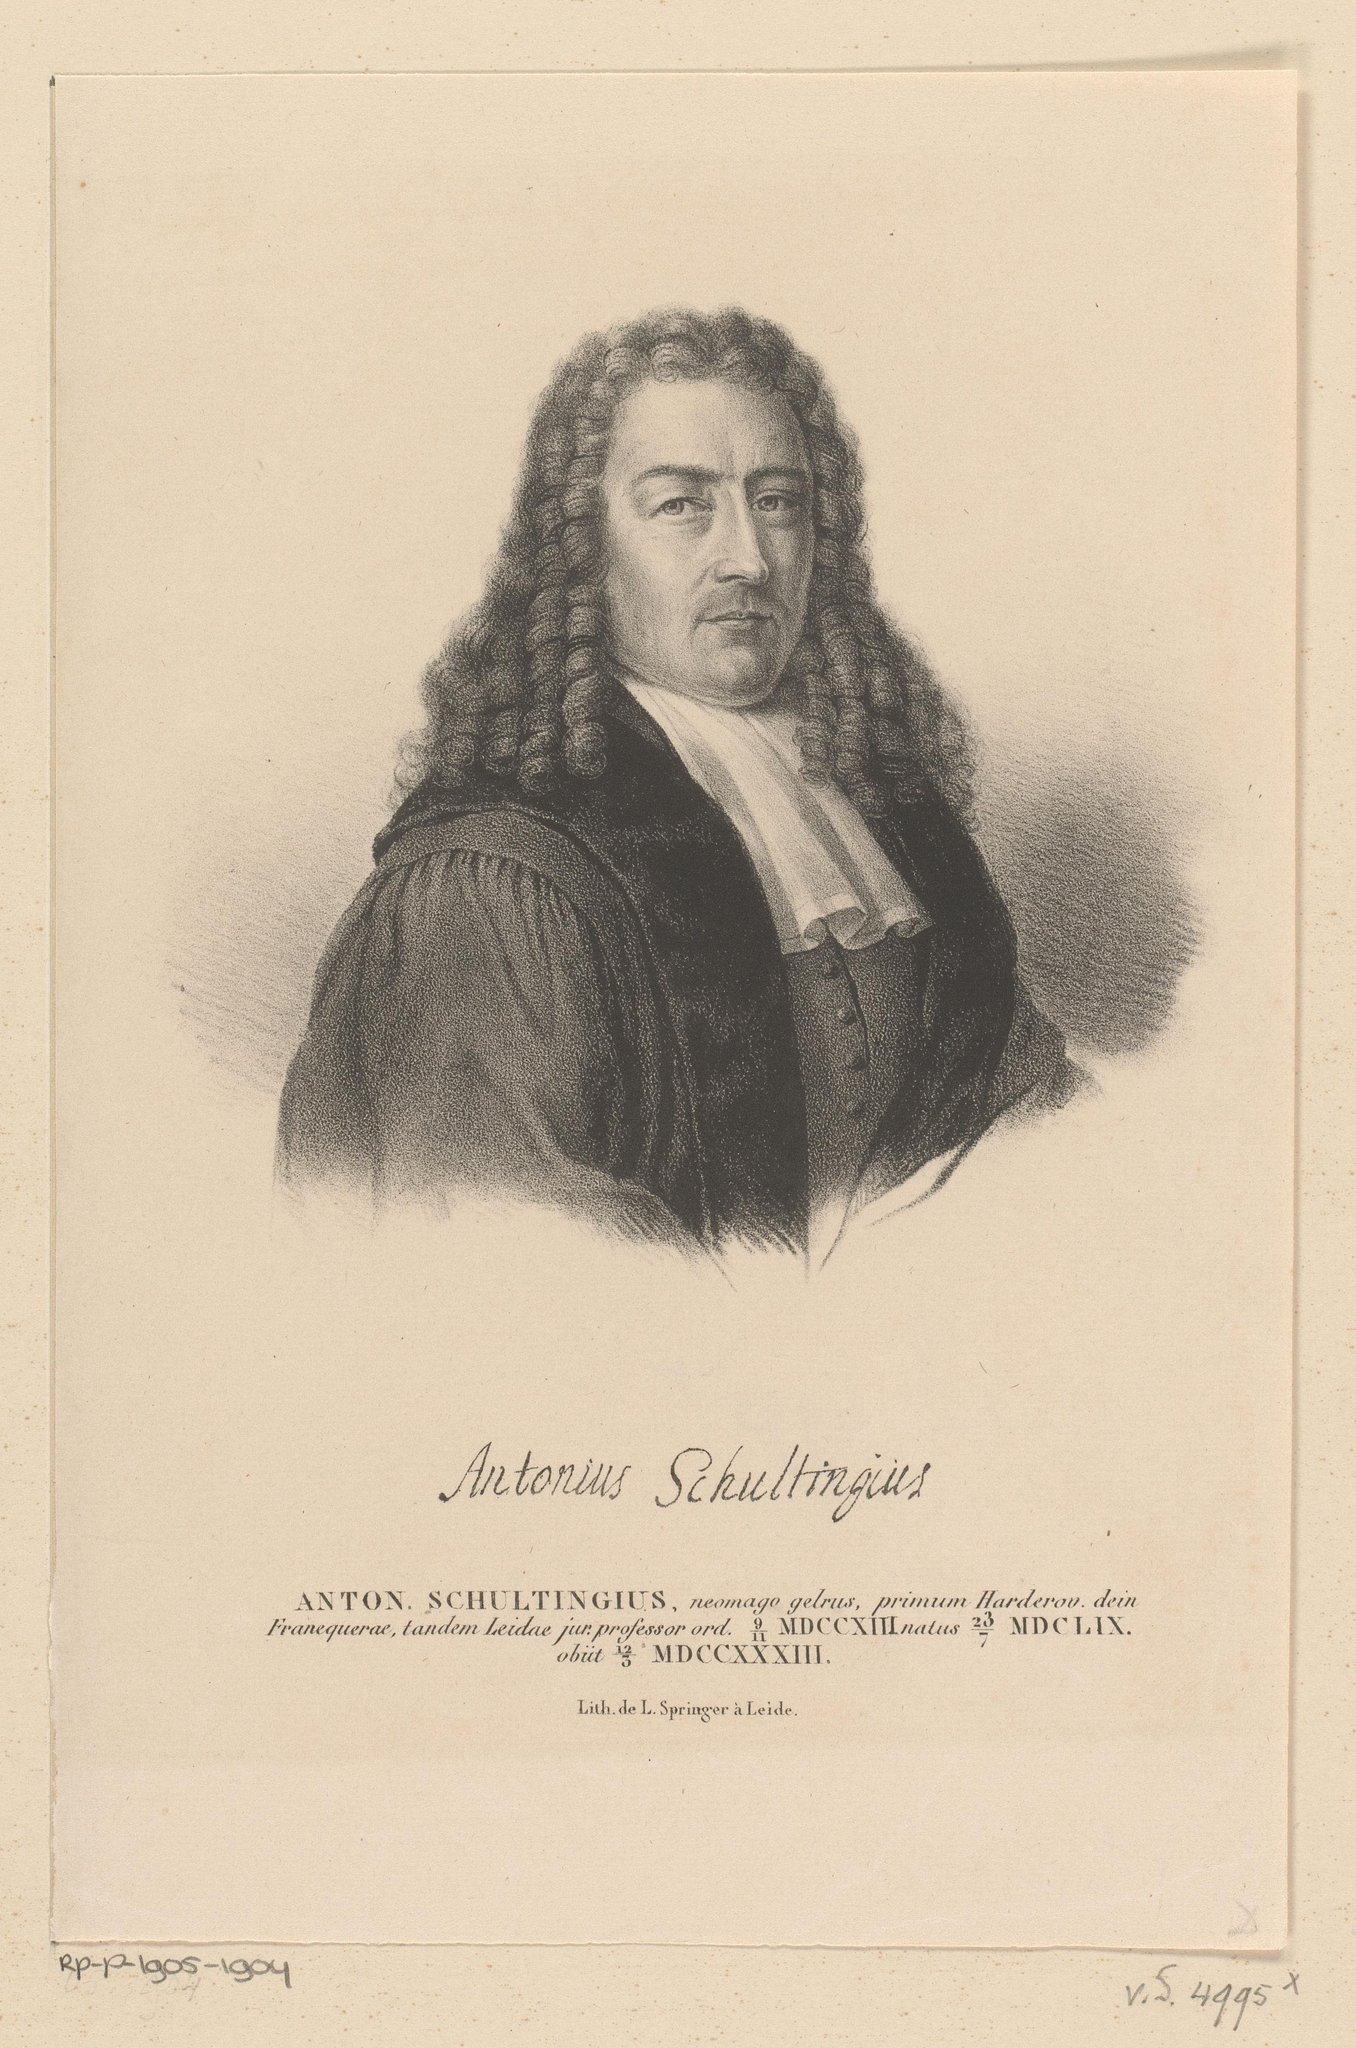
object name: print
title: Antonius Schultingius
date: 1835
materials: paper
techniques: lithograph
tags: nijmegen, historical persons, lawyer, attorney at law, portrait of a writer, professor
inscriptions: collector's mark: Lugt 2228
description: Prent waarschijnlijk uit: Schultingh, Antonius en Nicolaus Smallenburg. Antonii Schultingii, (quondam in academia Lugduno-Batava juris antecessoris celleberrimi), Notae ad Digesta seu Pandectas. Leiden: Samuel en Johannes Luchtmans, 1835, dl. 3.